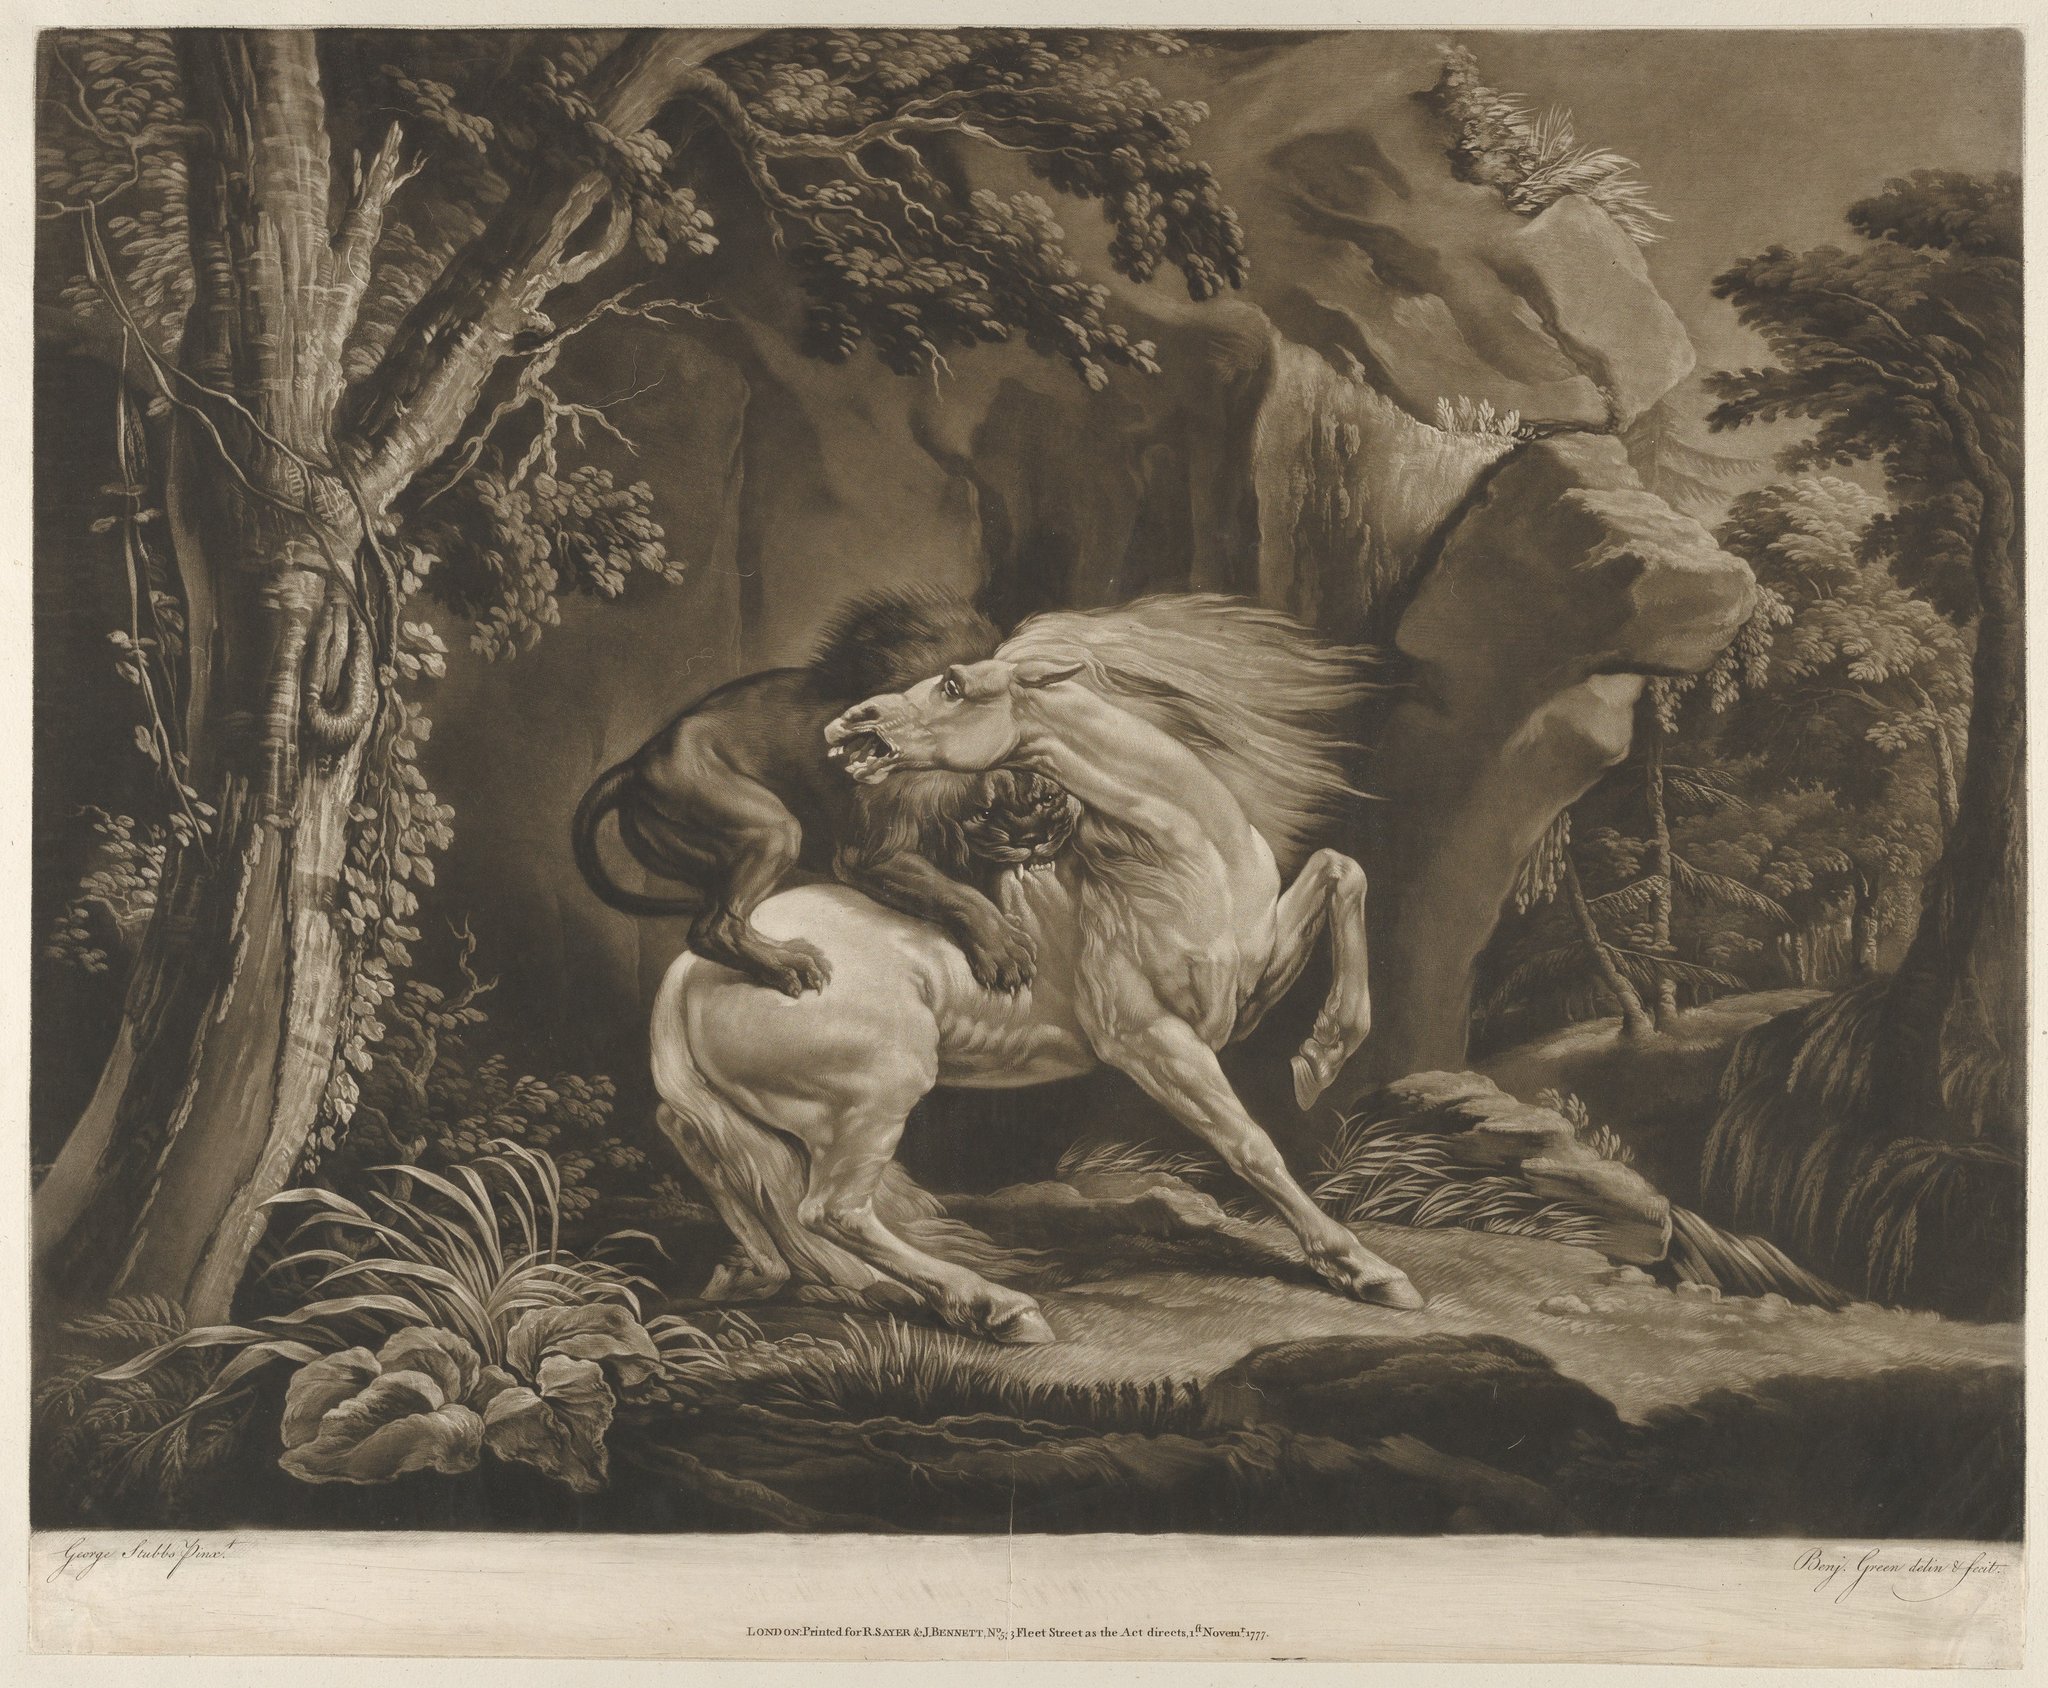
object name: print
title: The Lion and Horse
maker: benjamin green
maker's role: artist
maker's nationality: british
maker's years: 1739-1798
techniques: mezzotint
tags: horses,lions